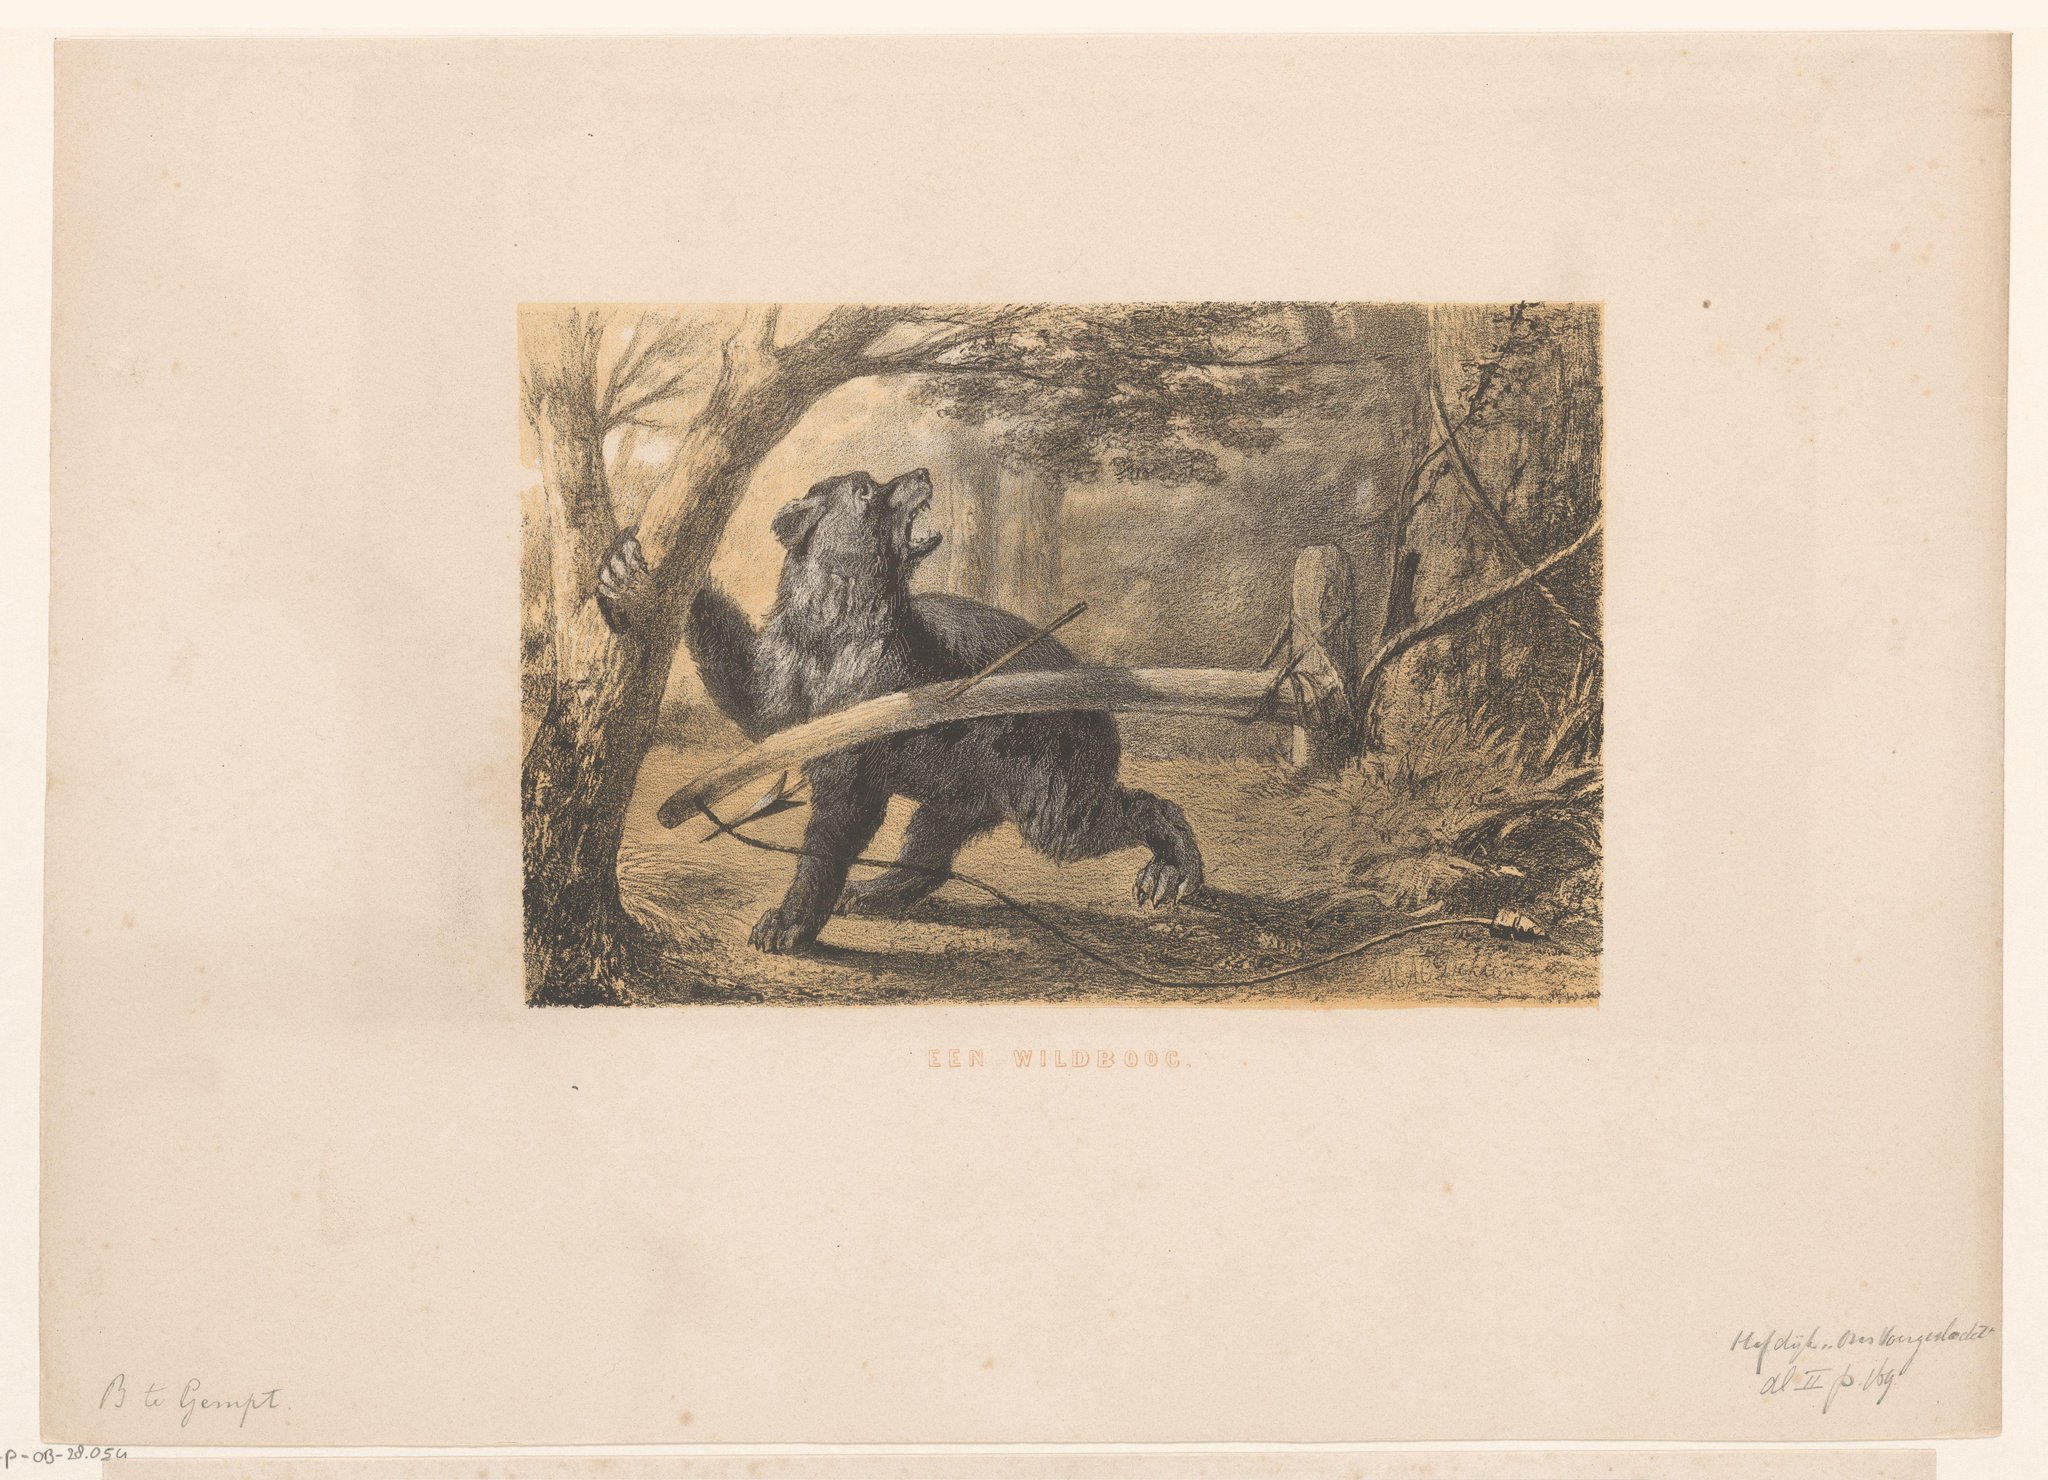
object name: print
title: Een wildboog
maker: hendrik adriaan christiaan dekker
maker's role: draughtsman, print maker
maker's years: 1836-1905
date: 1846-1905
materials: paper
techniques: tone lithography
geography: amsterdam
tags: casting weapons: spear, beasts of prey, predatory animals: bear, hunt ~ other mammals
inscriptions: collector's mark: Lugt 2228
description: De beer is in het bos in een val gelopen. Een pijl, bevestigd aan een grote houten boog, heeft hem doorboord. Hij heeft zijn bek open gesperd en met zijn rechterpoot klauwt hij in een boom.